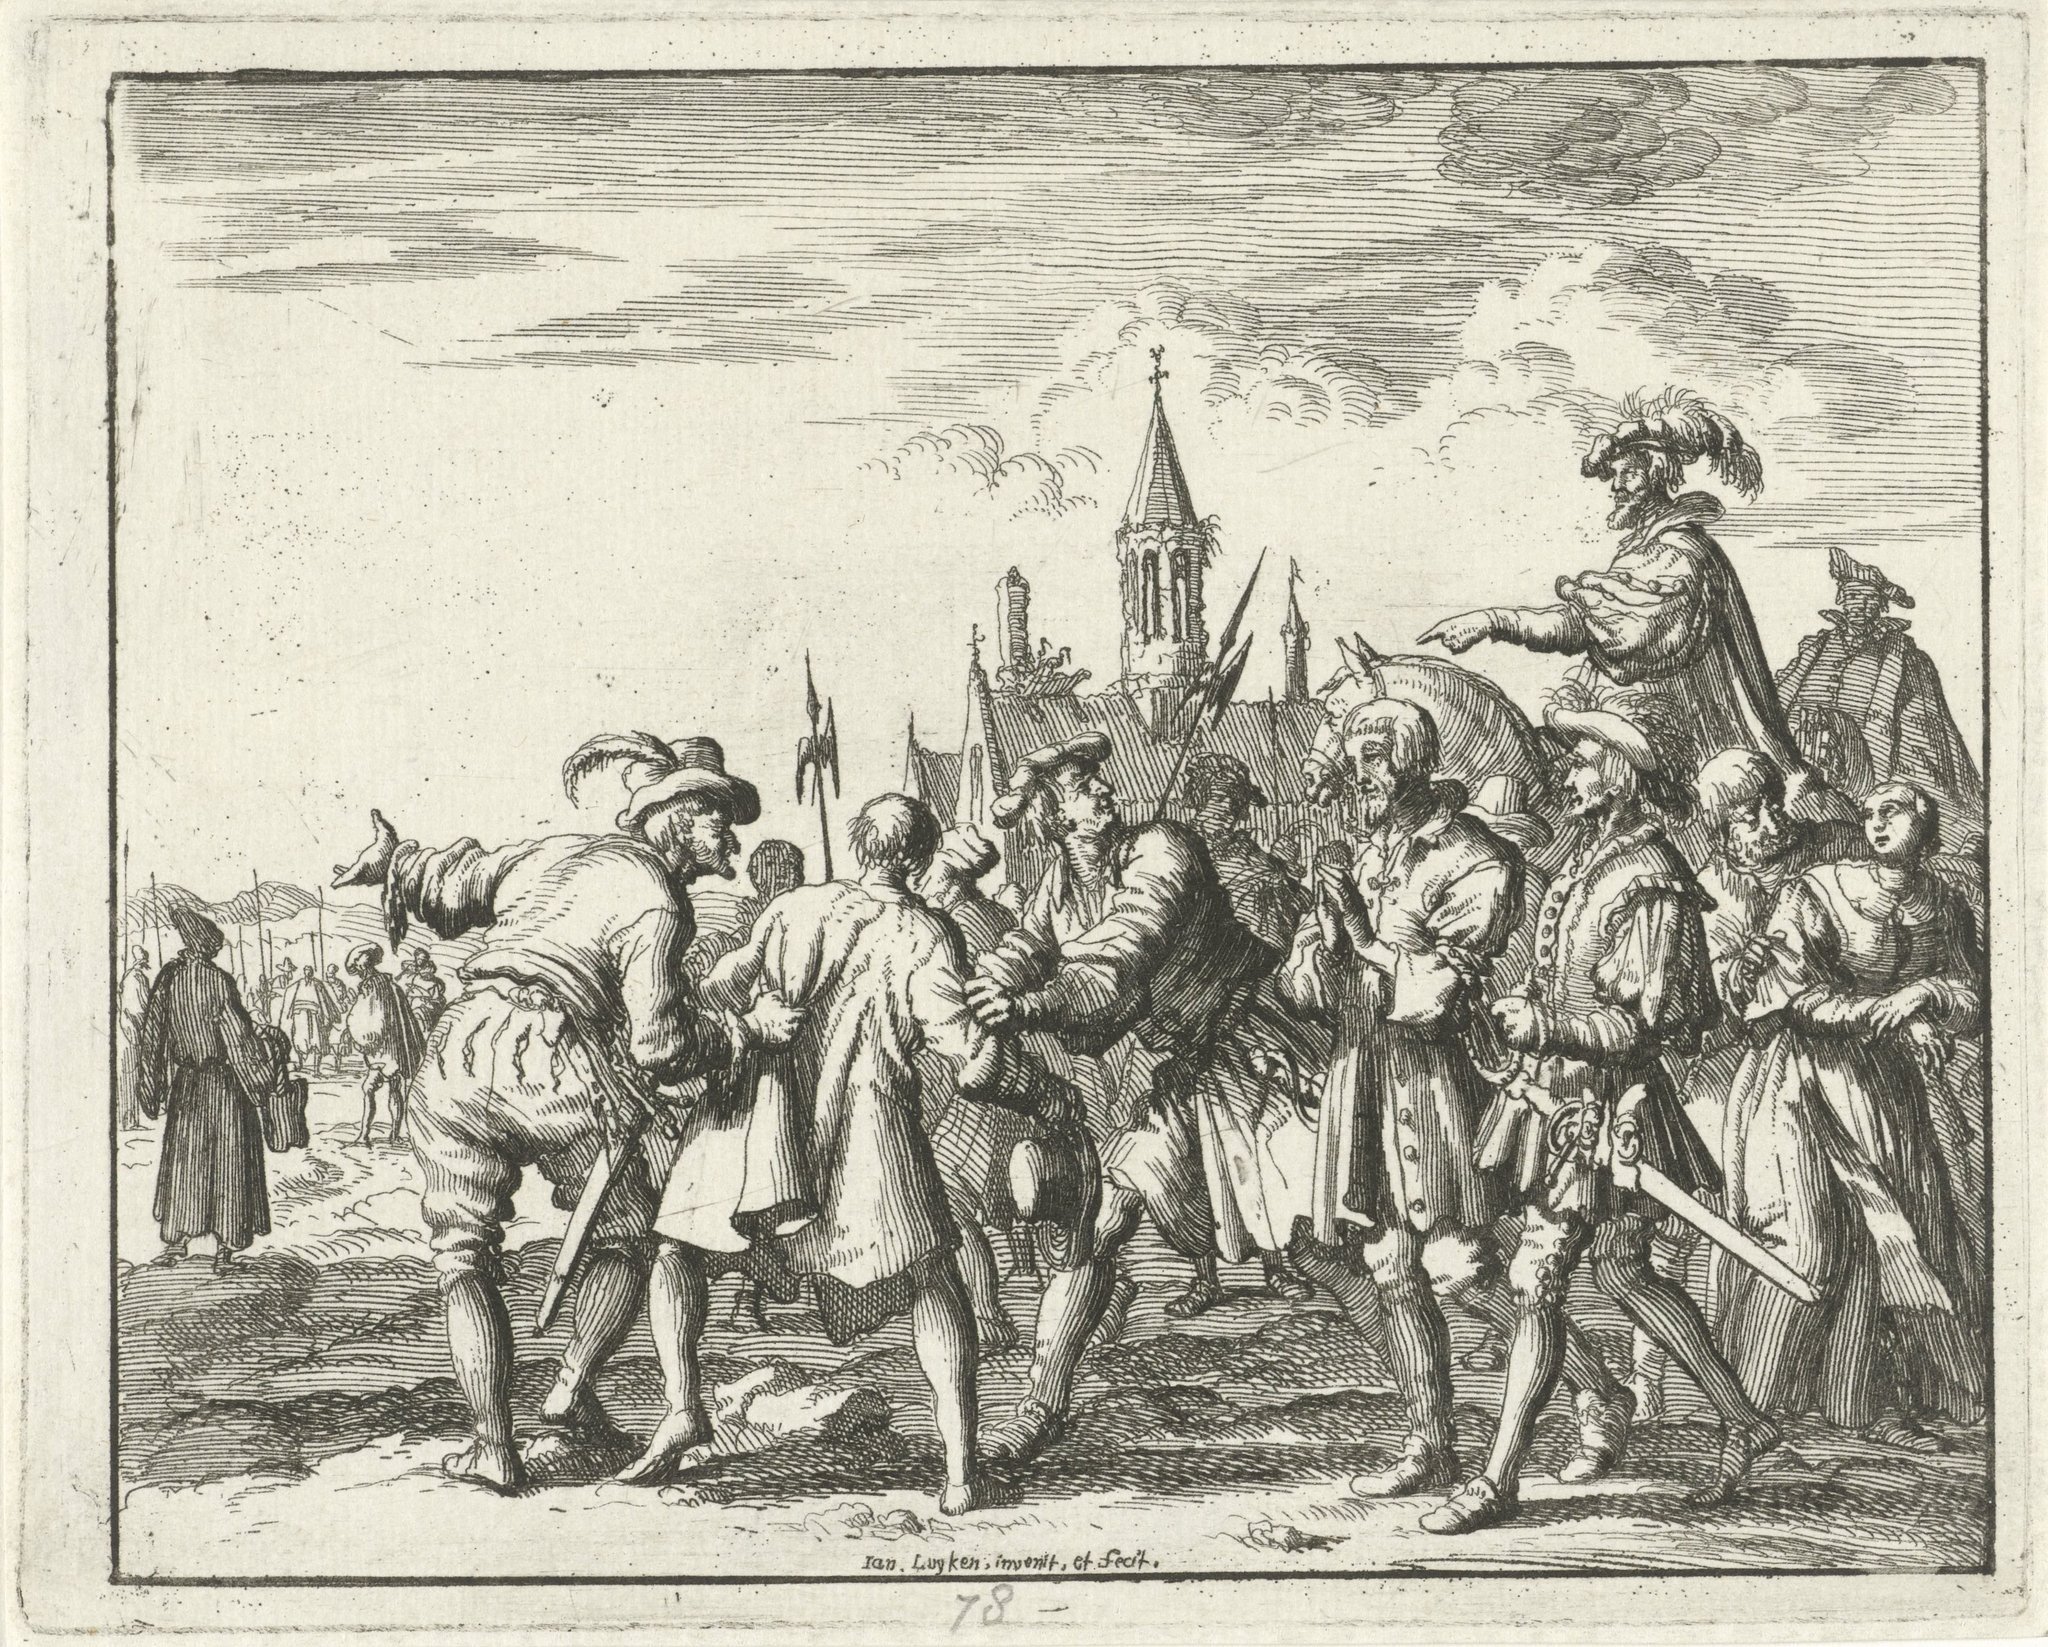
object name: book illustration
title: Matthijs Servaes te Keulen naar het schavot gevoerd, 1565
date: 1685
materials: paper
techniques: etching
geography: amsterdam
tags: persecution of heretics, (person under sentence of death) on the way to the scaffold or place of execution, cologne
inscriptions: number: ‘78’, collector's mark: Lugt 2228